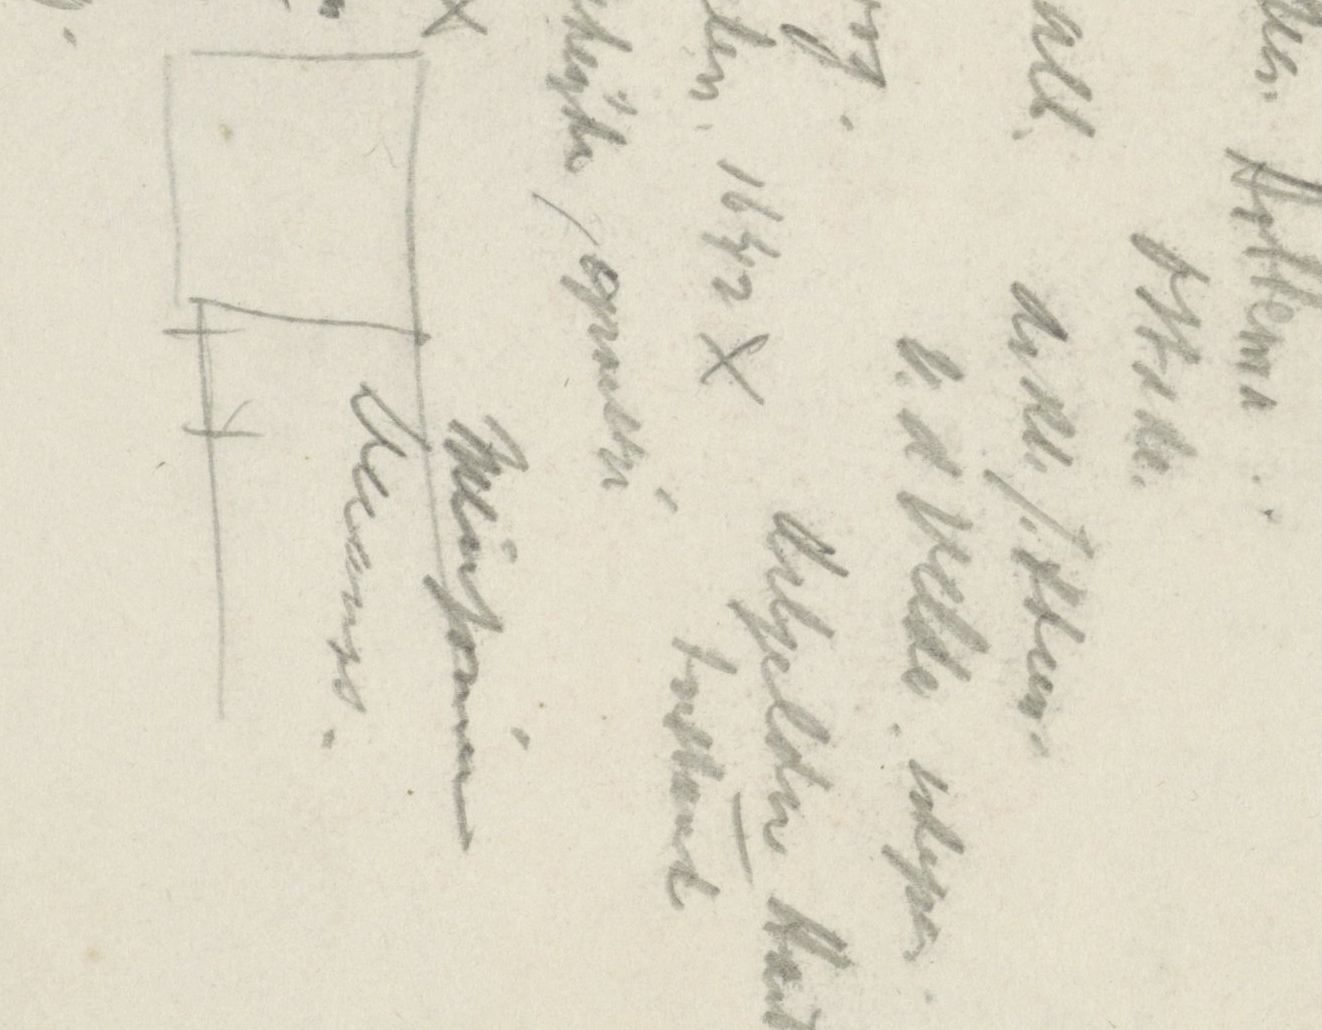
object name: sketchbook leaf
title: Annotaties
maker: george hendrik breitner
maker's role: draughtsman, painter, print maker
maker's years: 1857-1923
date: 1886-1895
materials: paper, pencil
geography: amsterdam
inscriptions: annotation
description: Pagina 68 uit een schetsboek met 34 bladen.